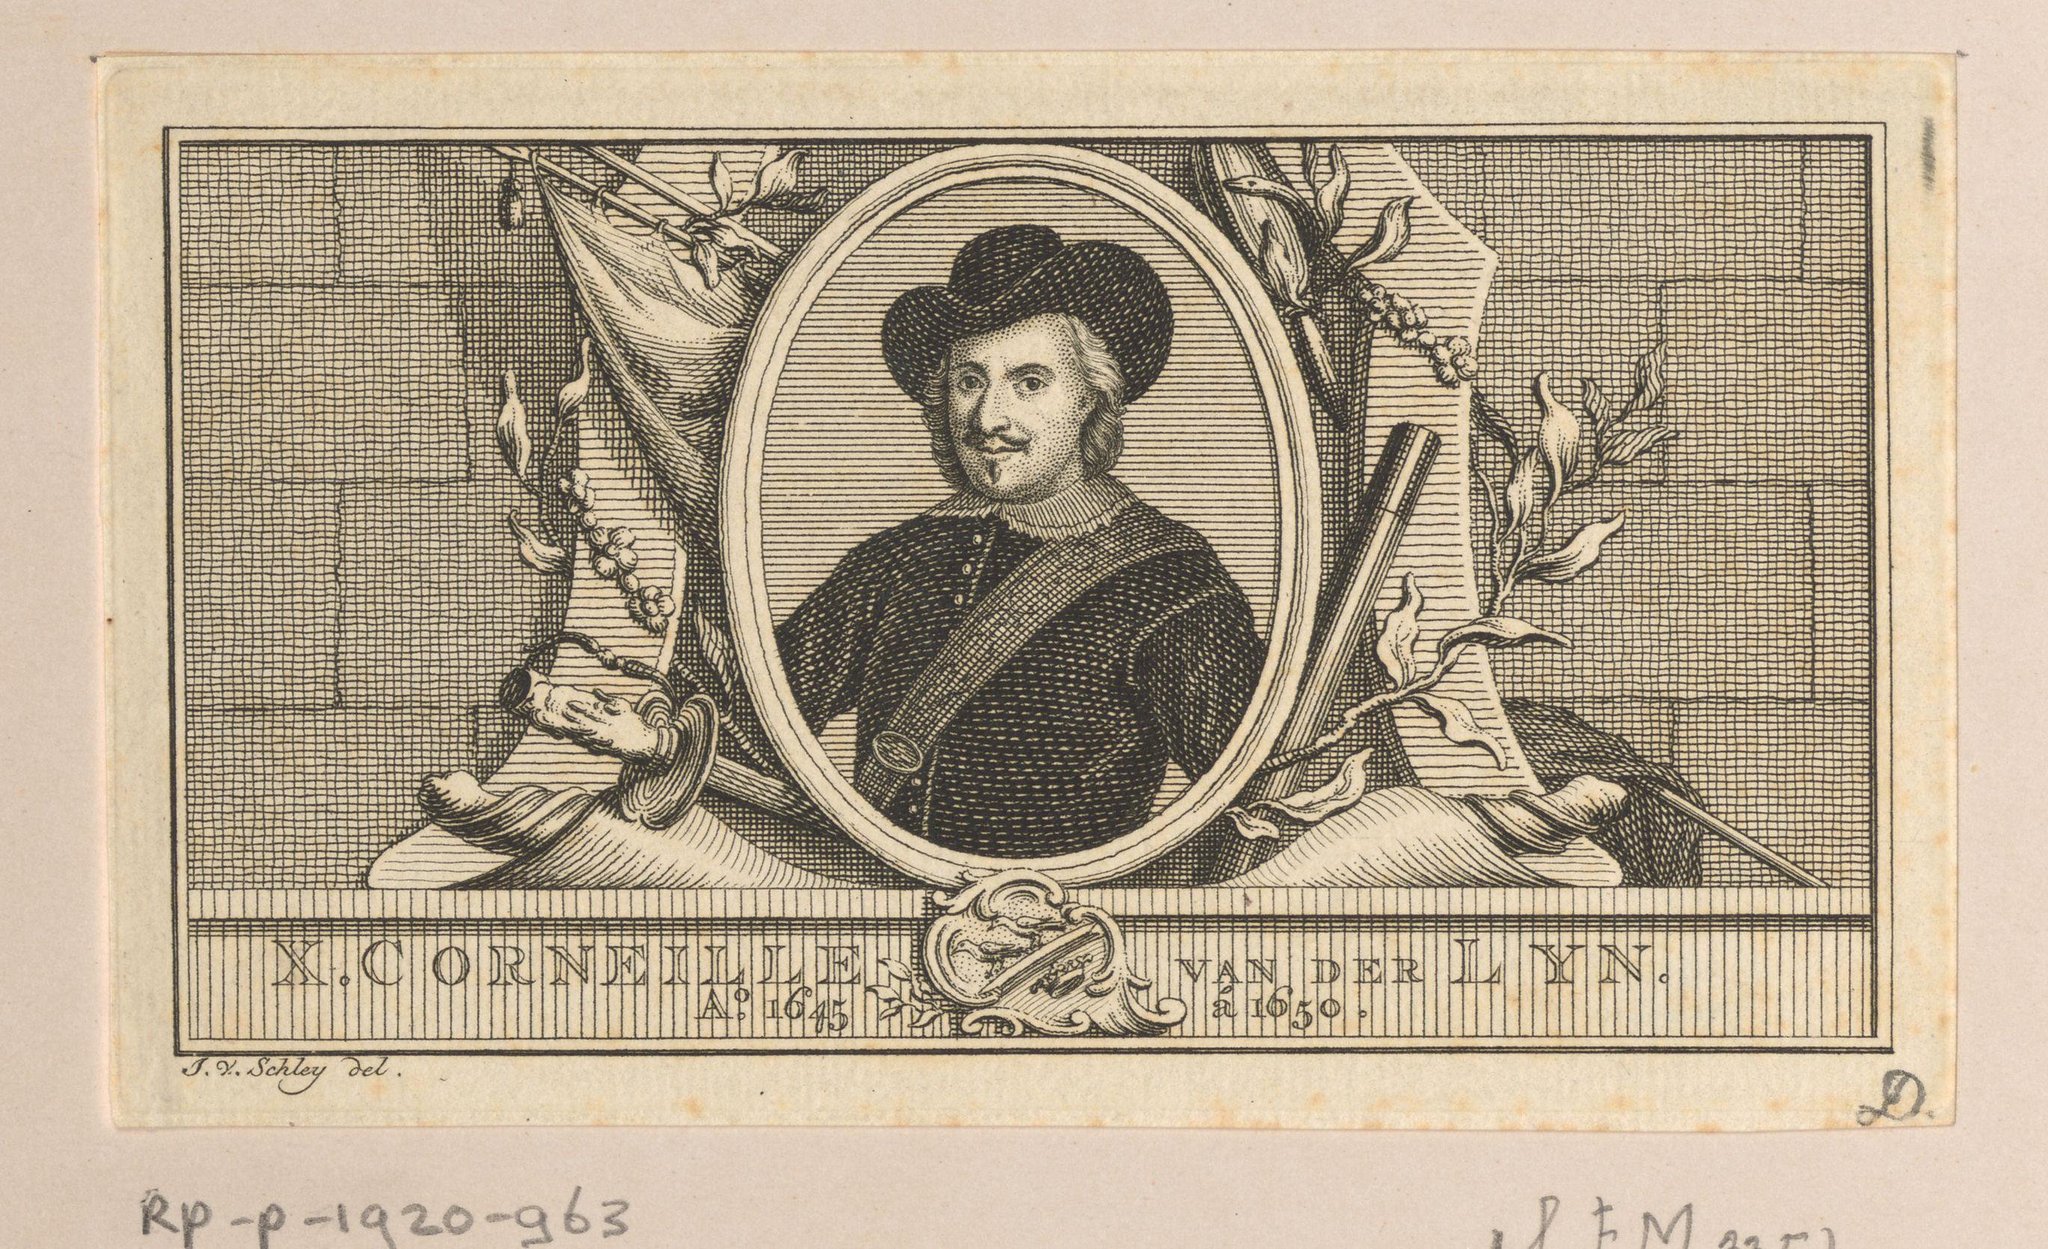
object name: book illustration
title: Portret van Cornelis van der Lijn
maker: jacob van der schley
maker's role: draughtsman, print maker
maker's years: 1715-1779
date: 1763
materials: paper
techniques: etching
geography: amsterdam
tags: ornament ~ medallion, commander-in-chief, general, marshal, historical persons, armorial bearing, heraldry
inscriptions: collector's mark: Lugt 964, collector's mark: Lugt 2228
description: Prent waarschijnlijk uit: Du Bois, J.P.J. Vies des gouverneurs généraux avec l'abrégé de l'histoire des établissemens hollandais aux Indes Orientales. Den Haag: Pieter de Hondt, 1763, p. 135.